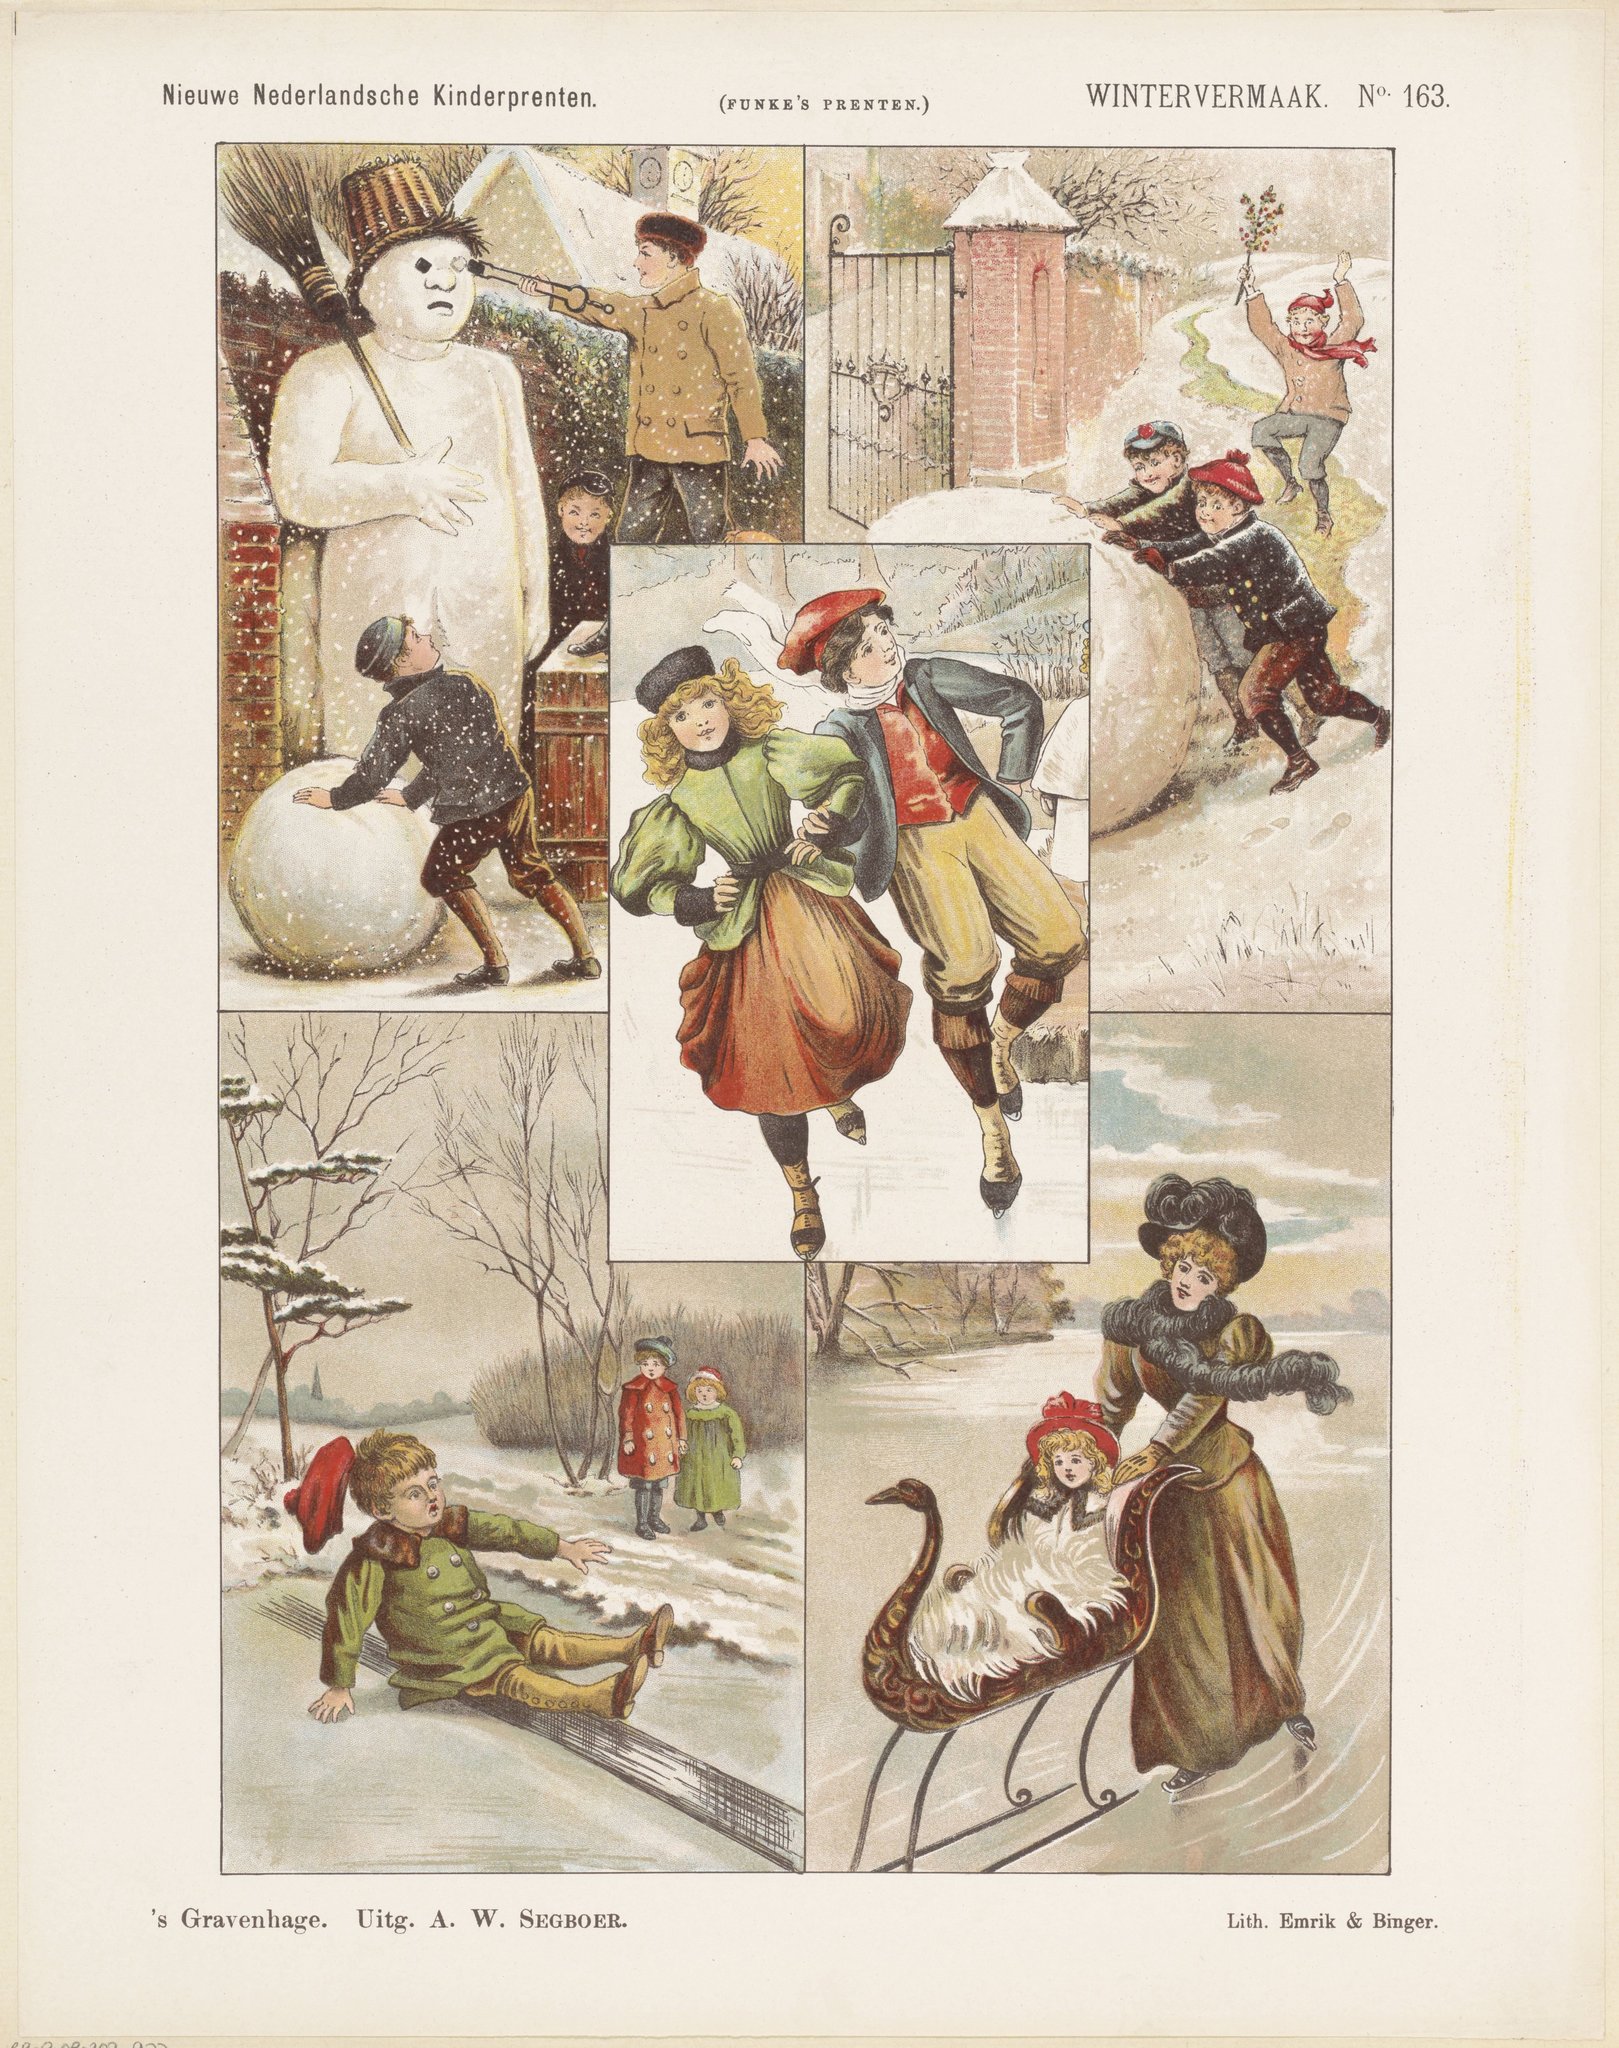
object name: popular print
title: Wintervermaak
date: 1903-1919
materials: paper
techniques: lithograph, letterpress printing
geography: the hague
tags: (making a) snowman, winter ~ human activities (the four seasons of the year), skates (winter sports), rolling up a snowball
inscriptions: collector's mark: Lugt 2760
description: Blad met 5 voorstellingen van winterse activiteiten, waaronder een sneeuwpop maken en schaatsen. Genummerd rechtsboven: No. 163.